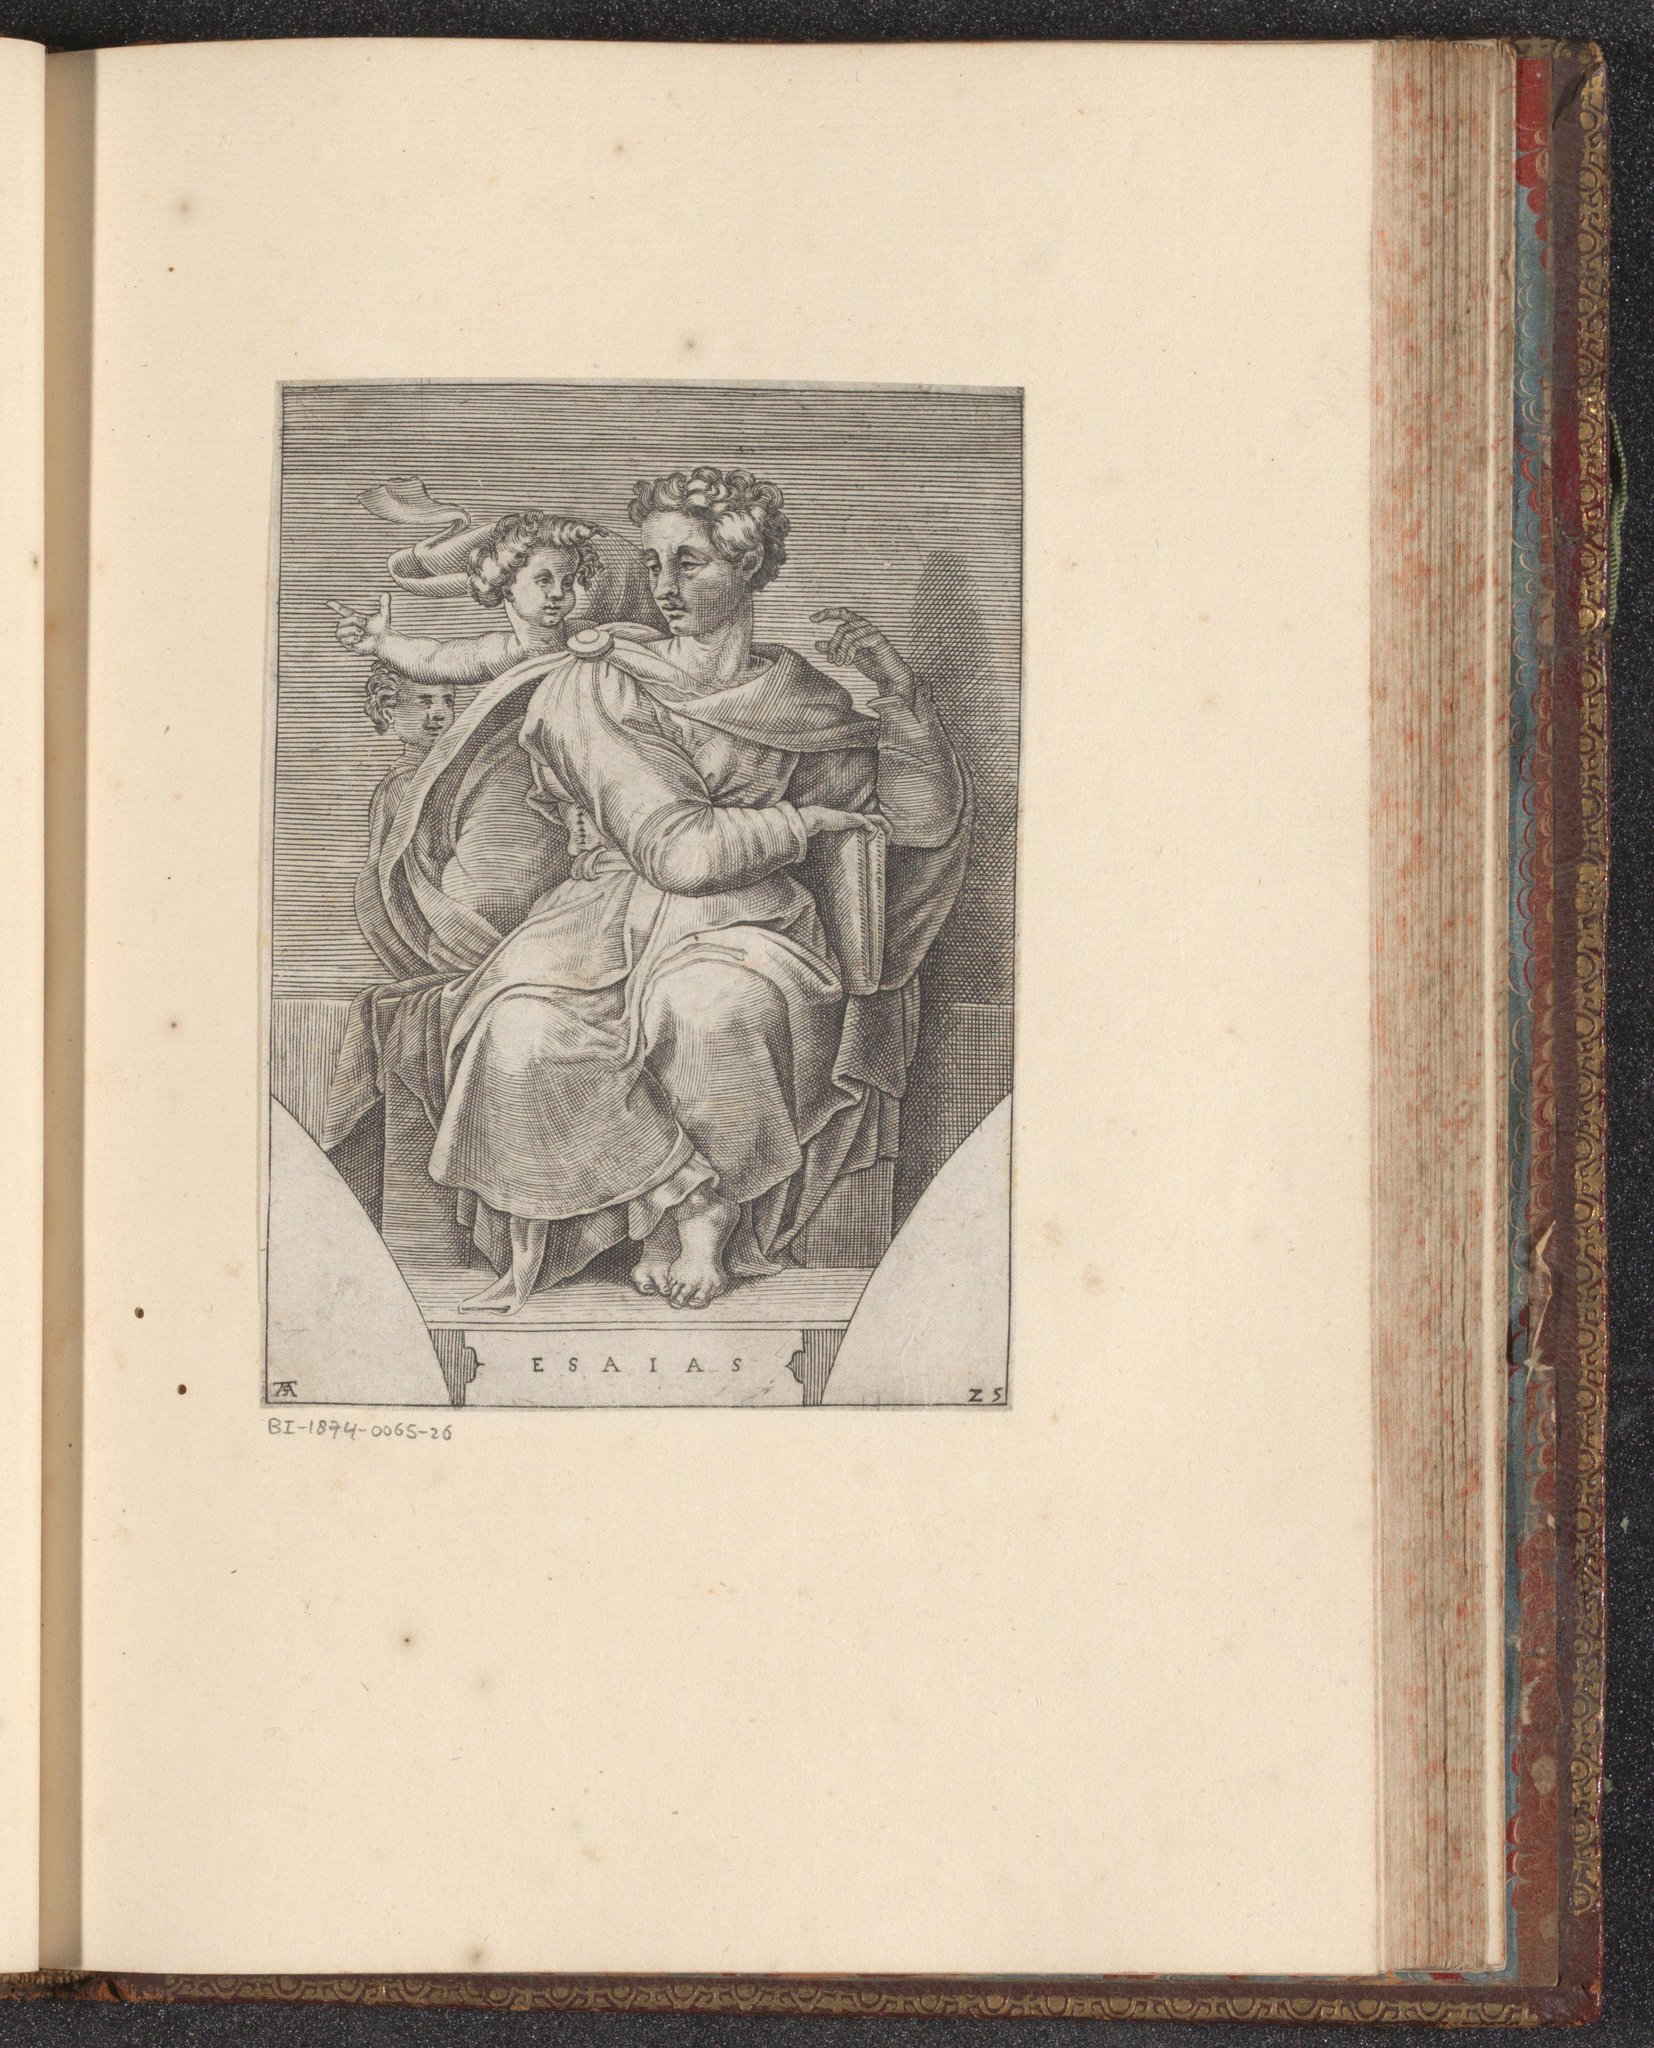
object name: album leaf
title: Profeet Jesaja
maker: adamo scultori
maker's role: painter, print maker, sculptor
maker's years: 1530-1585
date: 1585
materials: paper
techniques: engraving, intaglio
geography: vatican city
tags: isaiah (not in biblical context); possible attributes: branch with leaves, saw, scroll or book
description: De profeet Jesaja zittend met een boek. Achter de profeet twee kleine figuren. Eén van de profeten van Michelangelo's plafondschildering. Titel in ondermarge en genummerd rechtsonder: 25. De prent maakt deel uit van een album.